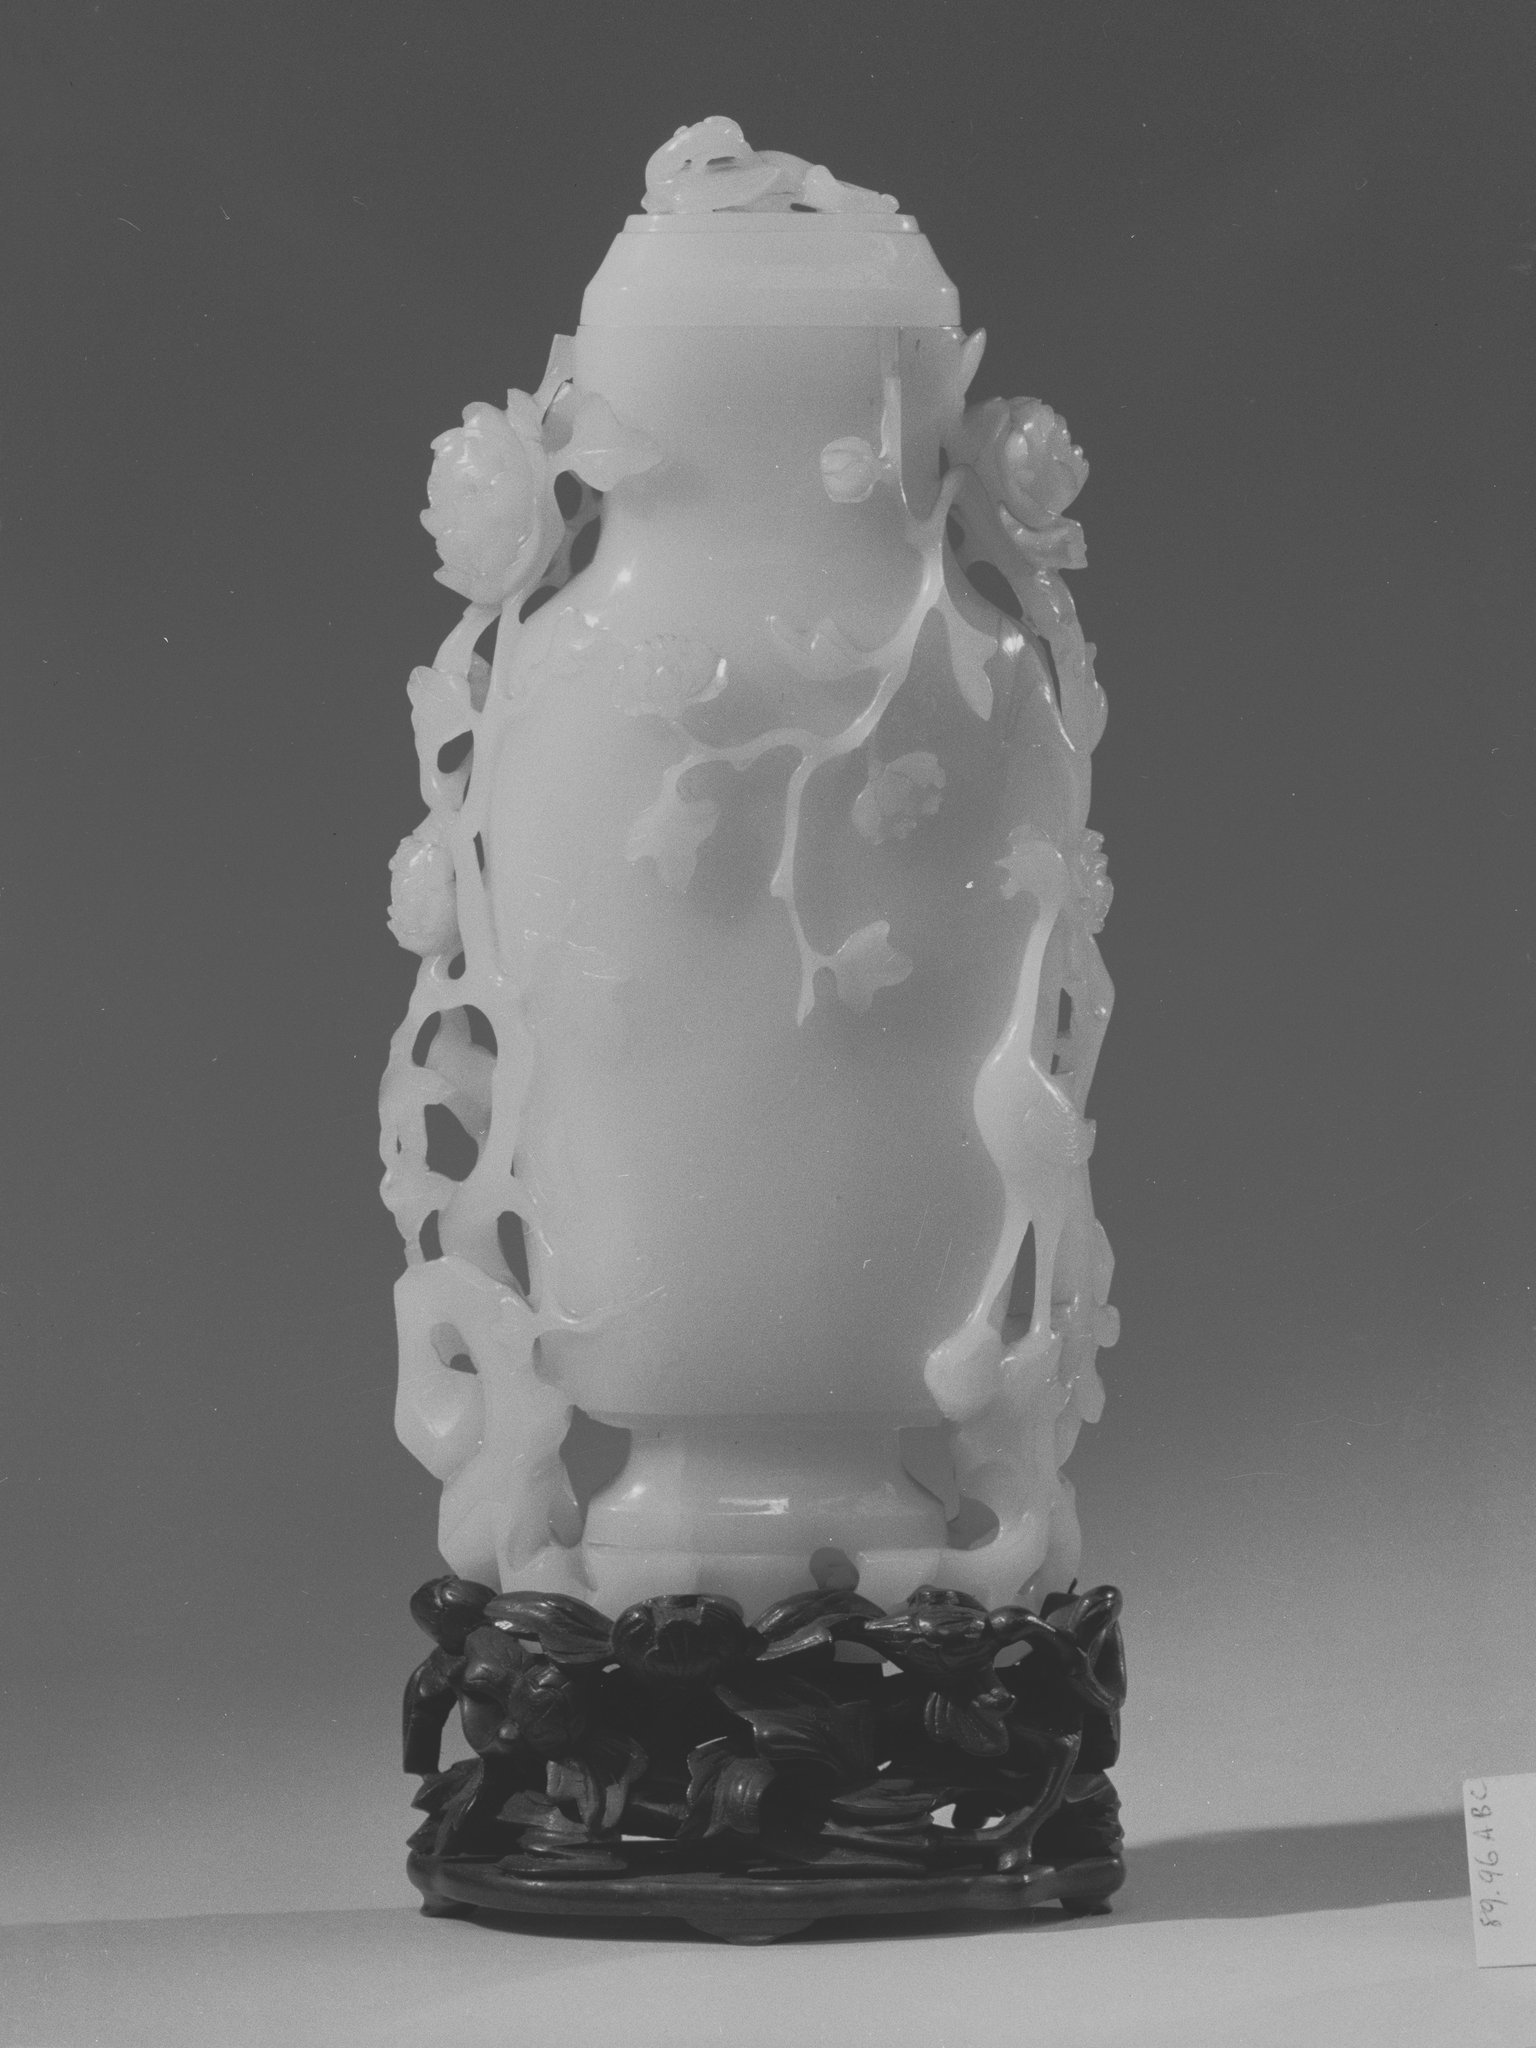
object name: vase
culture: chinese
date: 1801-1900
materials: jade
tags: flowers